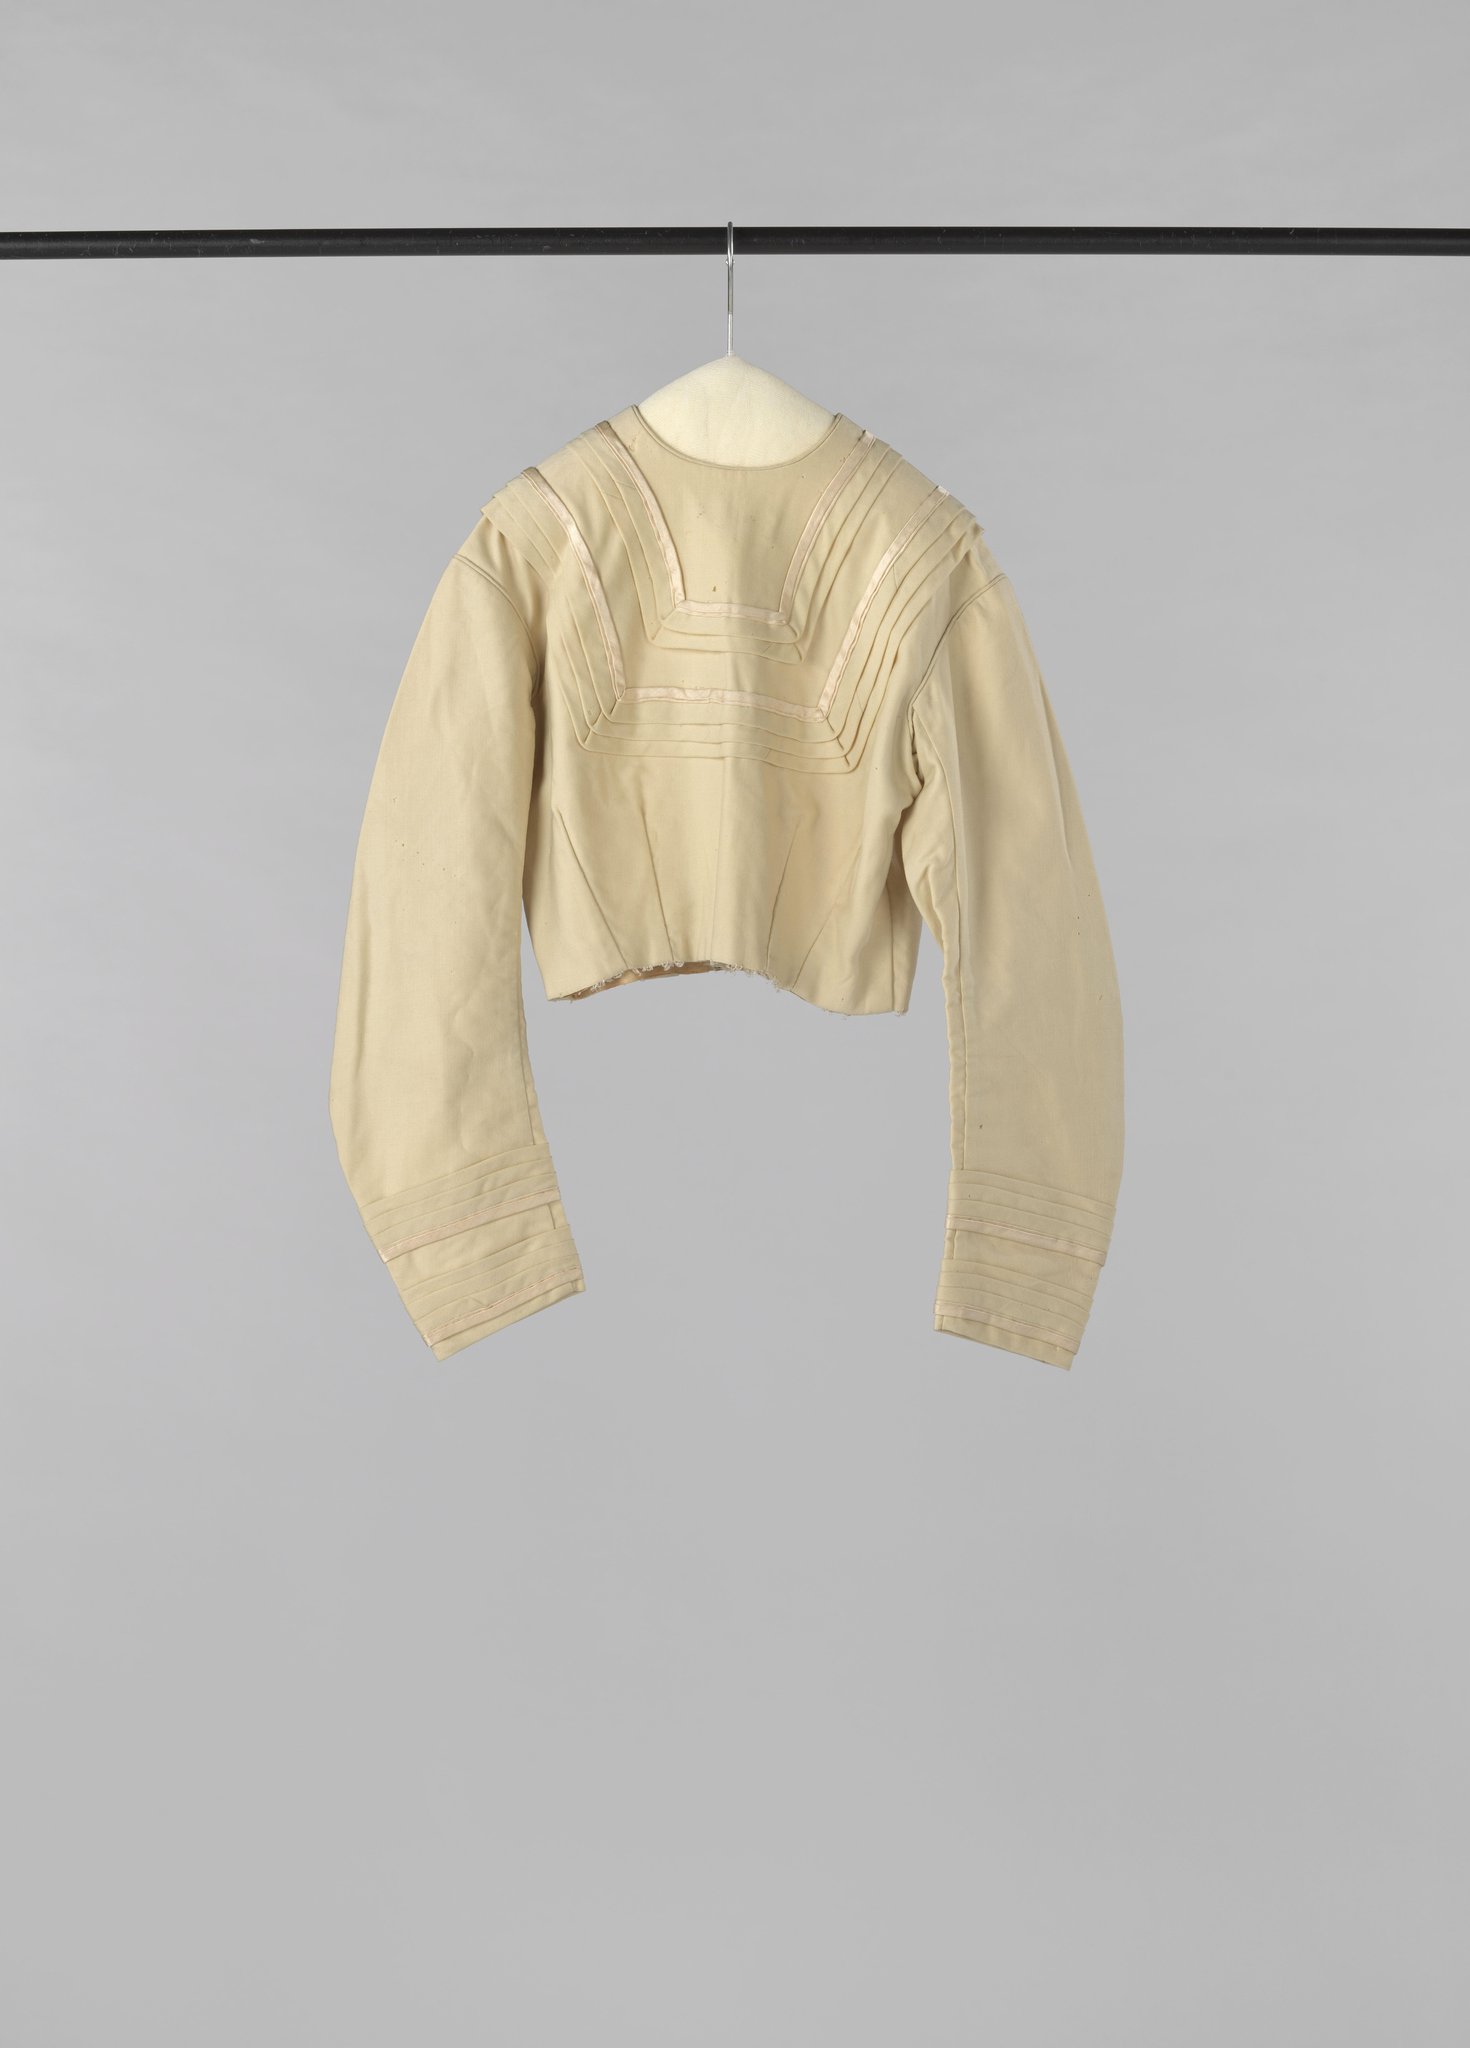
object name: corsage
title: Lijf van meisjesjurk van wit laken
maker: Anonymous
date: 1880-1890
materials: textile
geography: netherlands